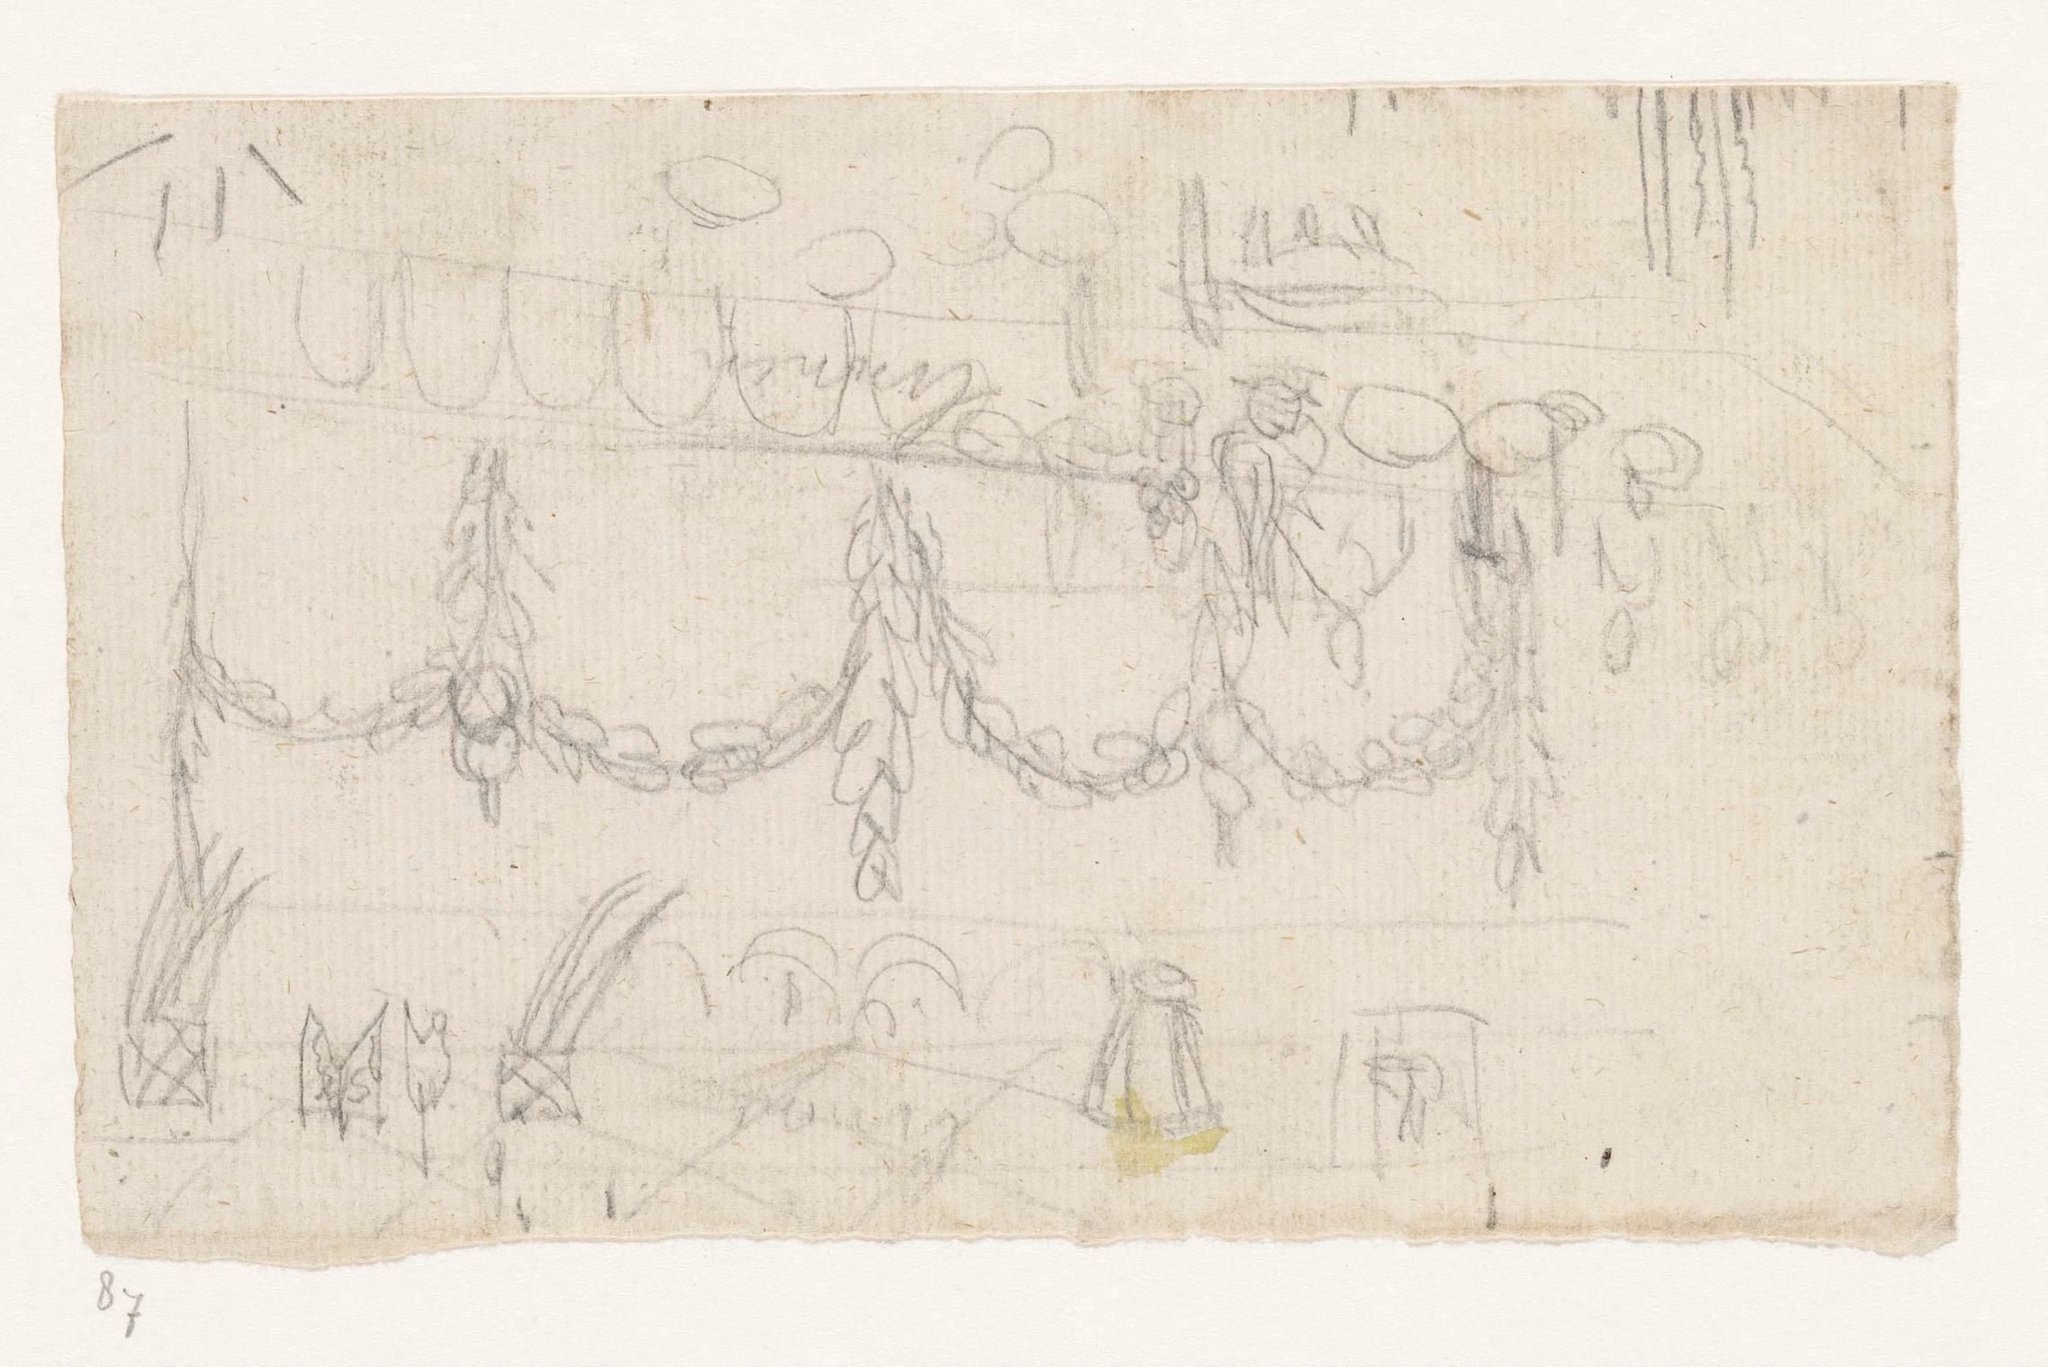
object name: drawing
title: Schetsblaadje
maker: jan brandes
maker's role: draughtsman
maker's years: 1743-1808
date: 1770-1808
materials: paper, pencil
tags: ornament ~ festoon, garland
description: Schets van een gebouw of vertrek versierd met ranken. Opschrift: 'linnen'.